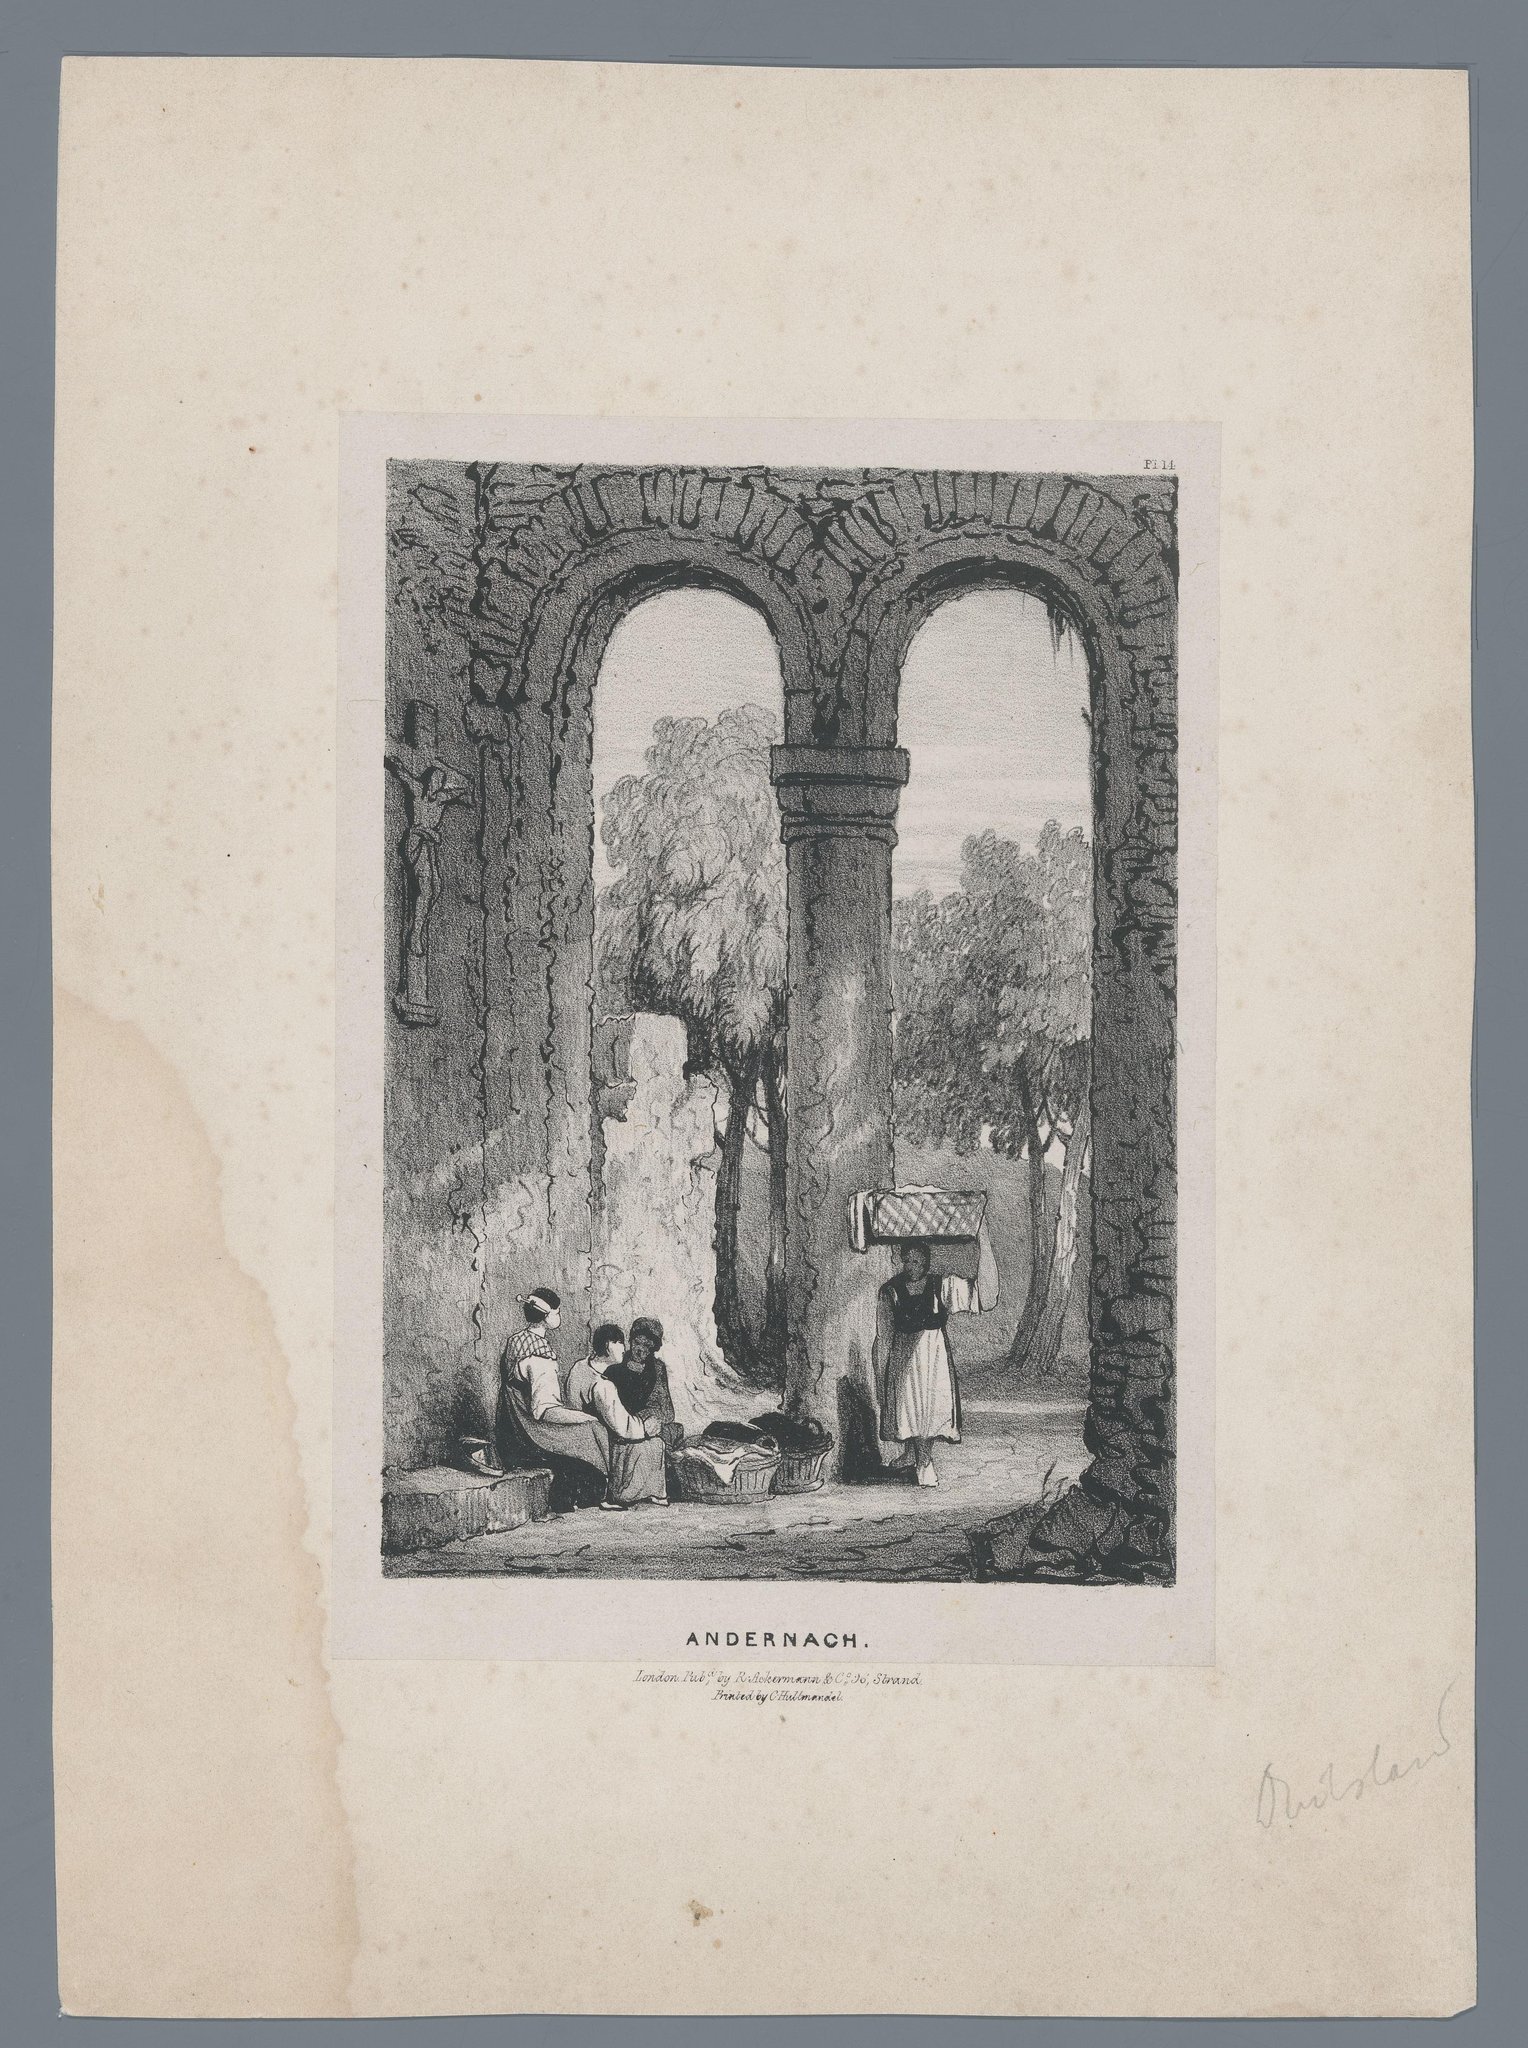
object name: print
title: Wasvrouwen onder twee bogen in Andernach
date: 1832-1850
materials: paper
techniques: lithograph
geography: london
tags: arch, archivolt ~ architecture, laundering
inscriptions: collector's mark: Lugt 2228